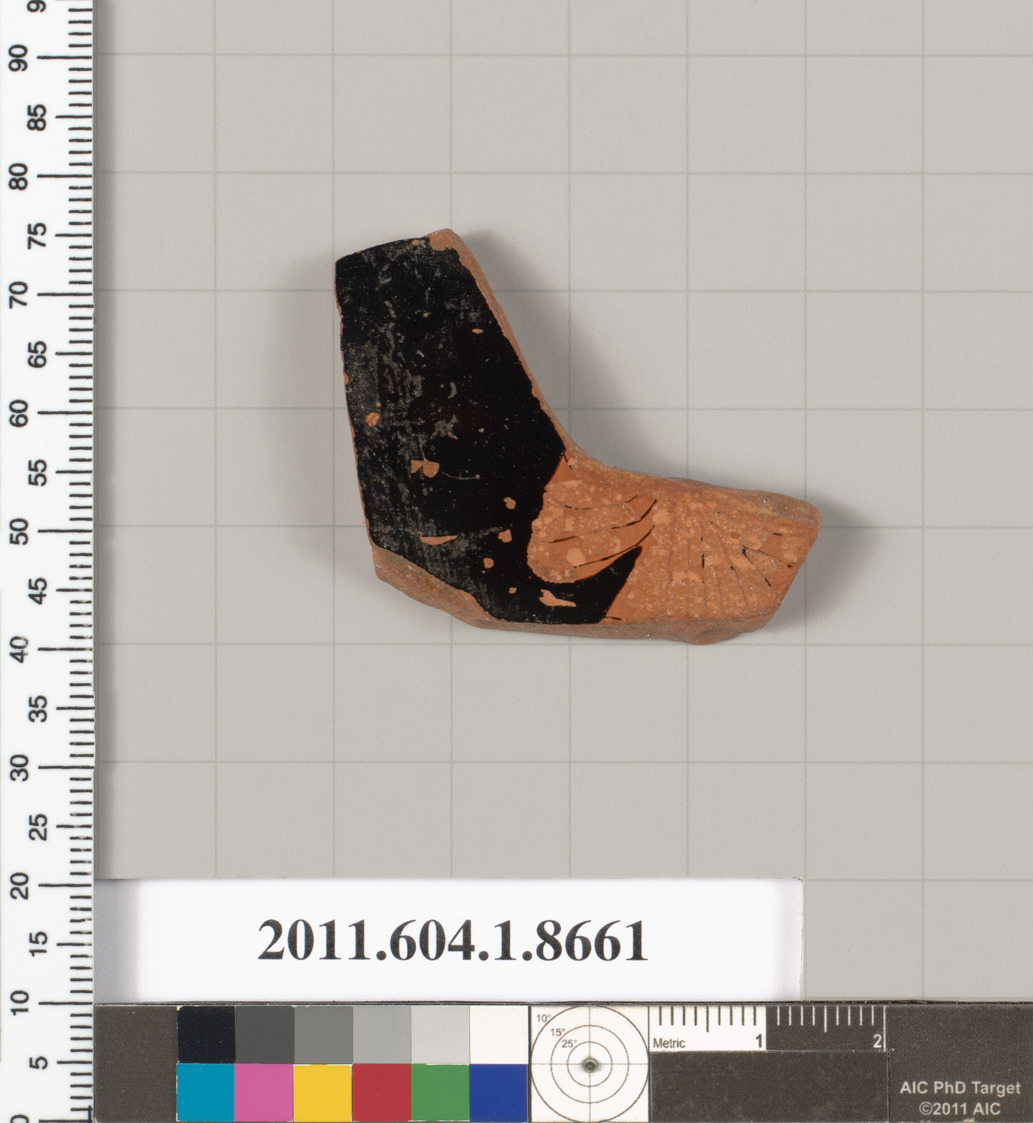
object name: kylix fragment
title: Terracotta rim fragment of a stemless? kylix (drinking cup)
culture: greek, attic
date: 460-450 BCE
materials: terracotta